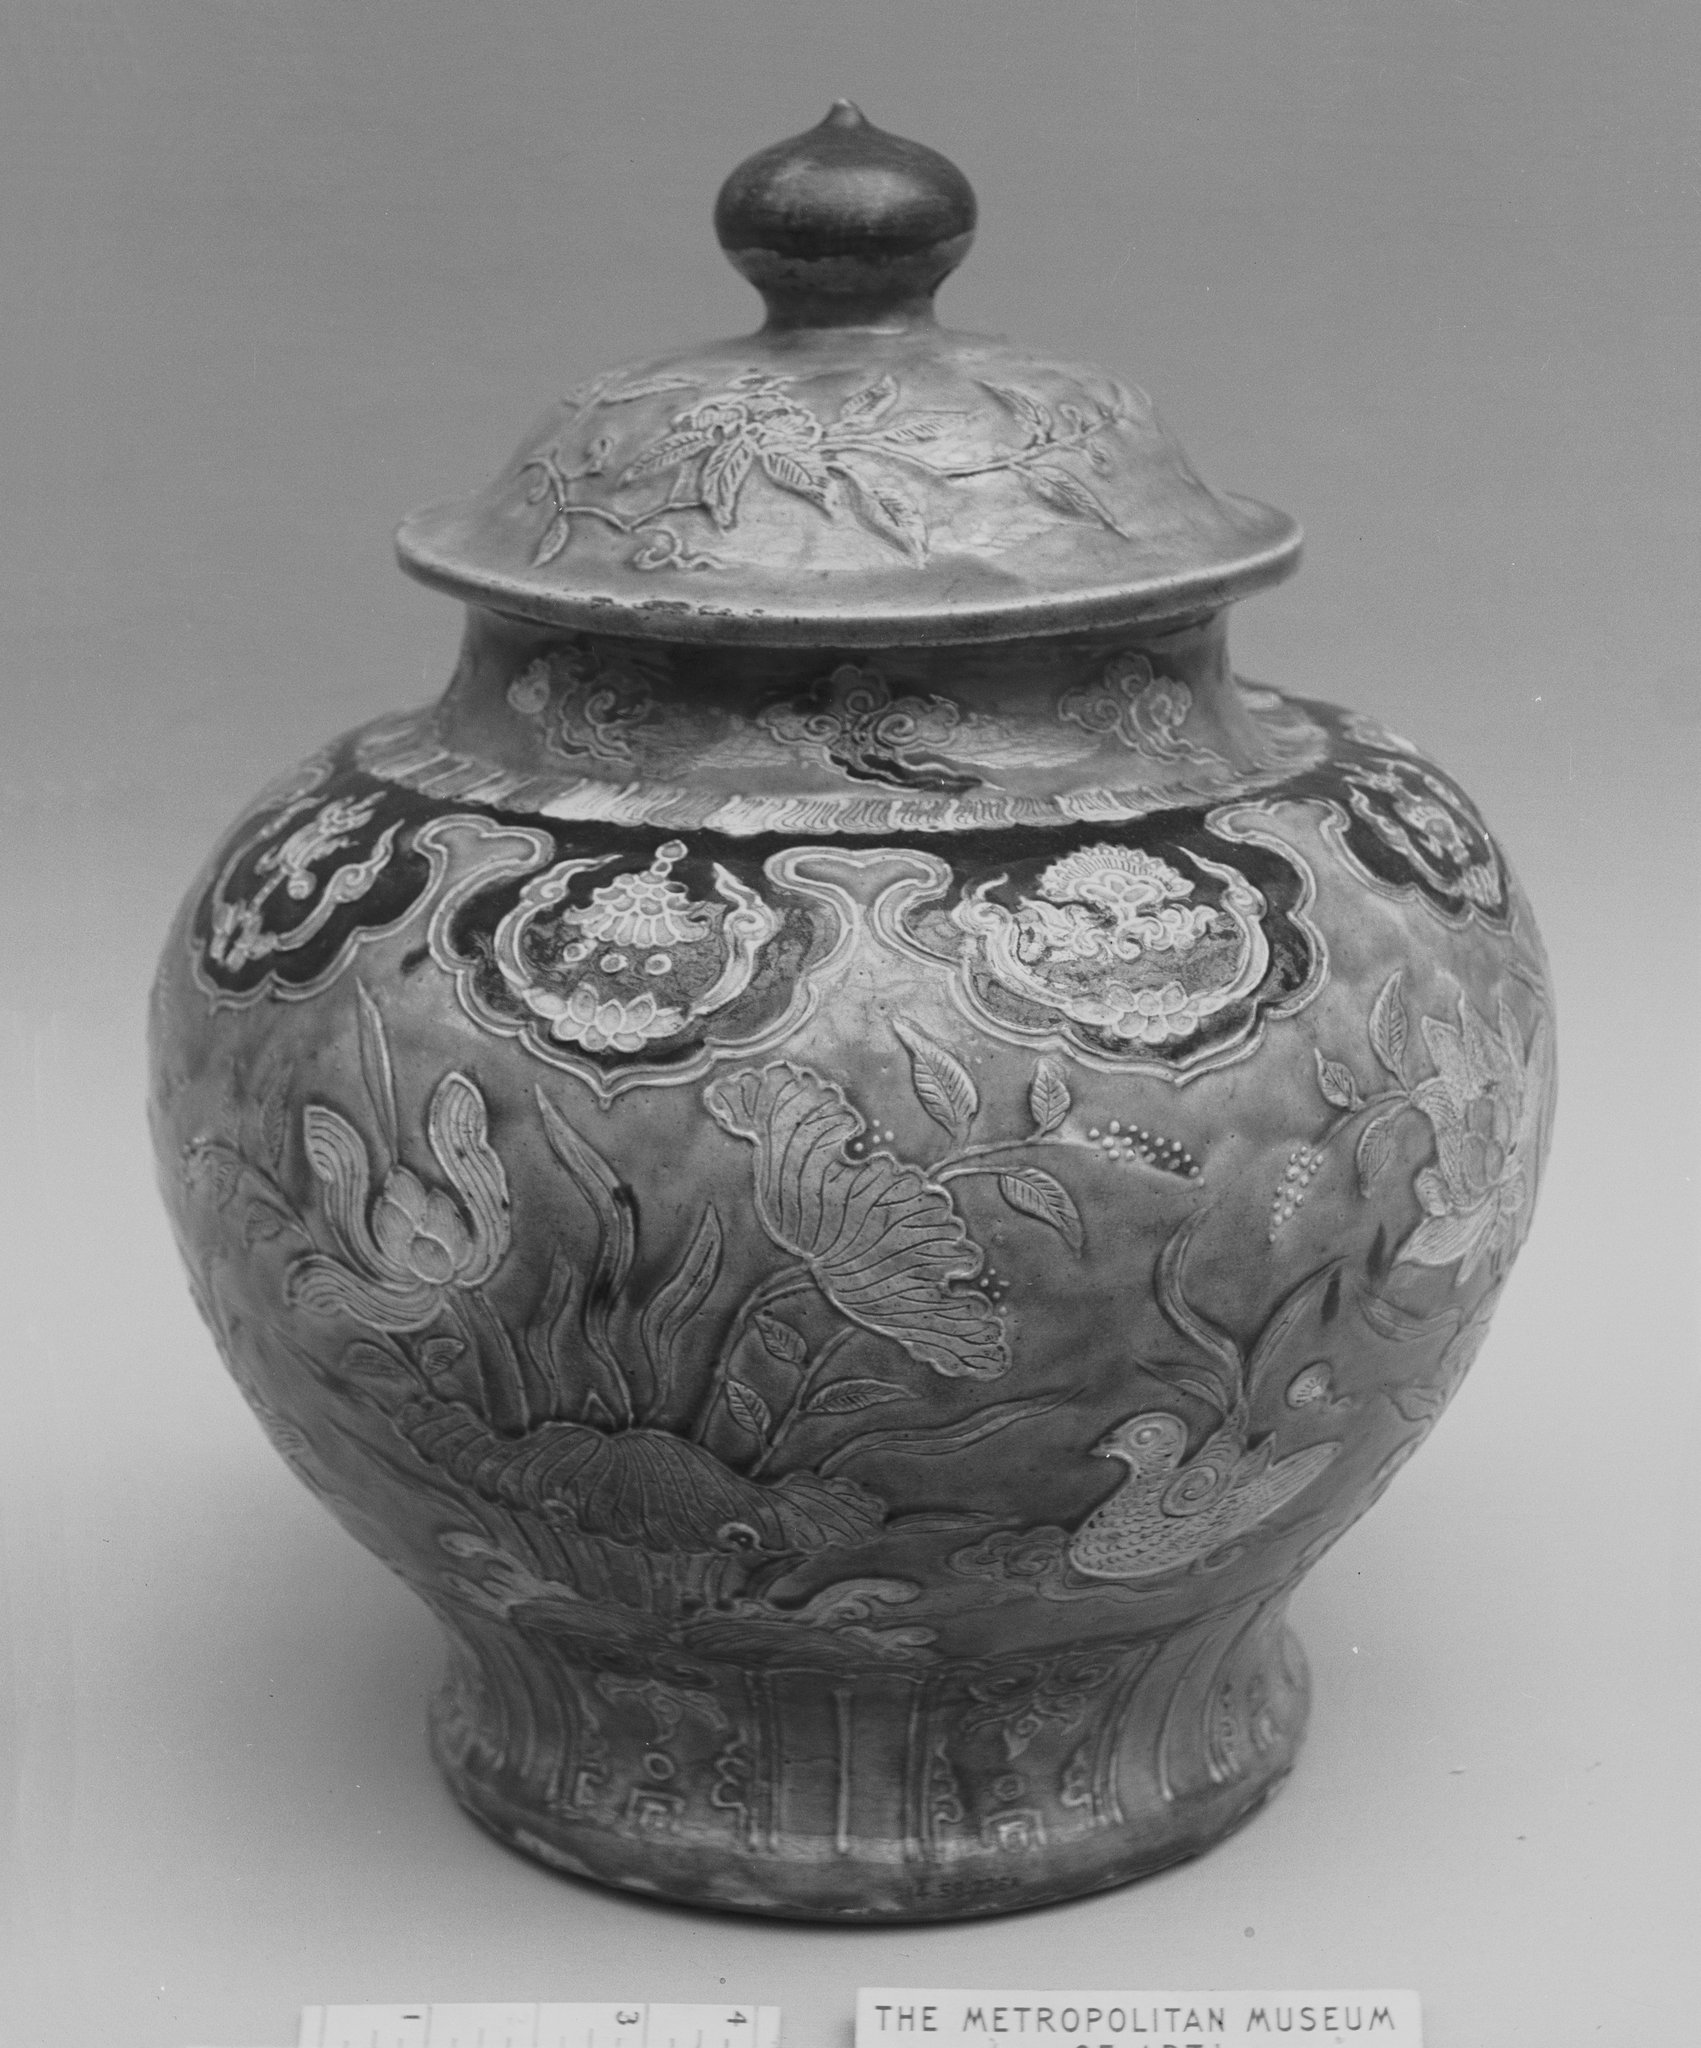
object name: covered jar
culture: chinese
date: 1501-1600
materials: porcelain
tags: birds,flowers